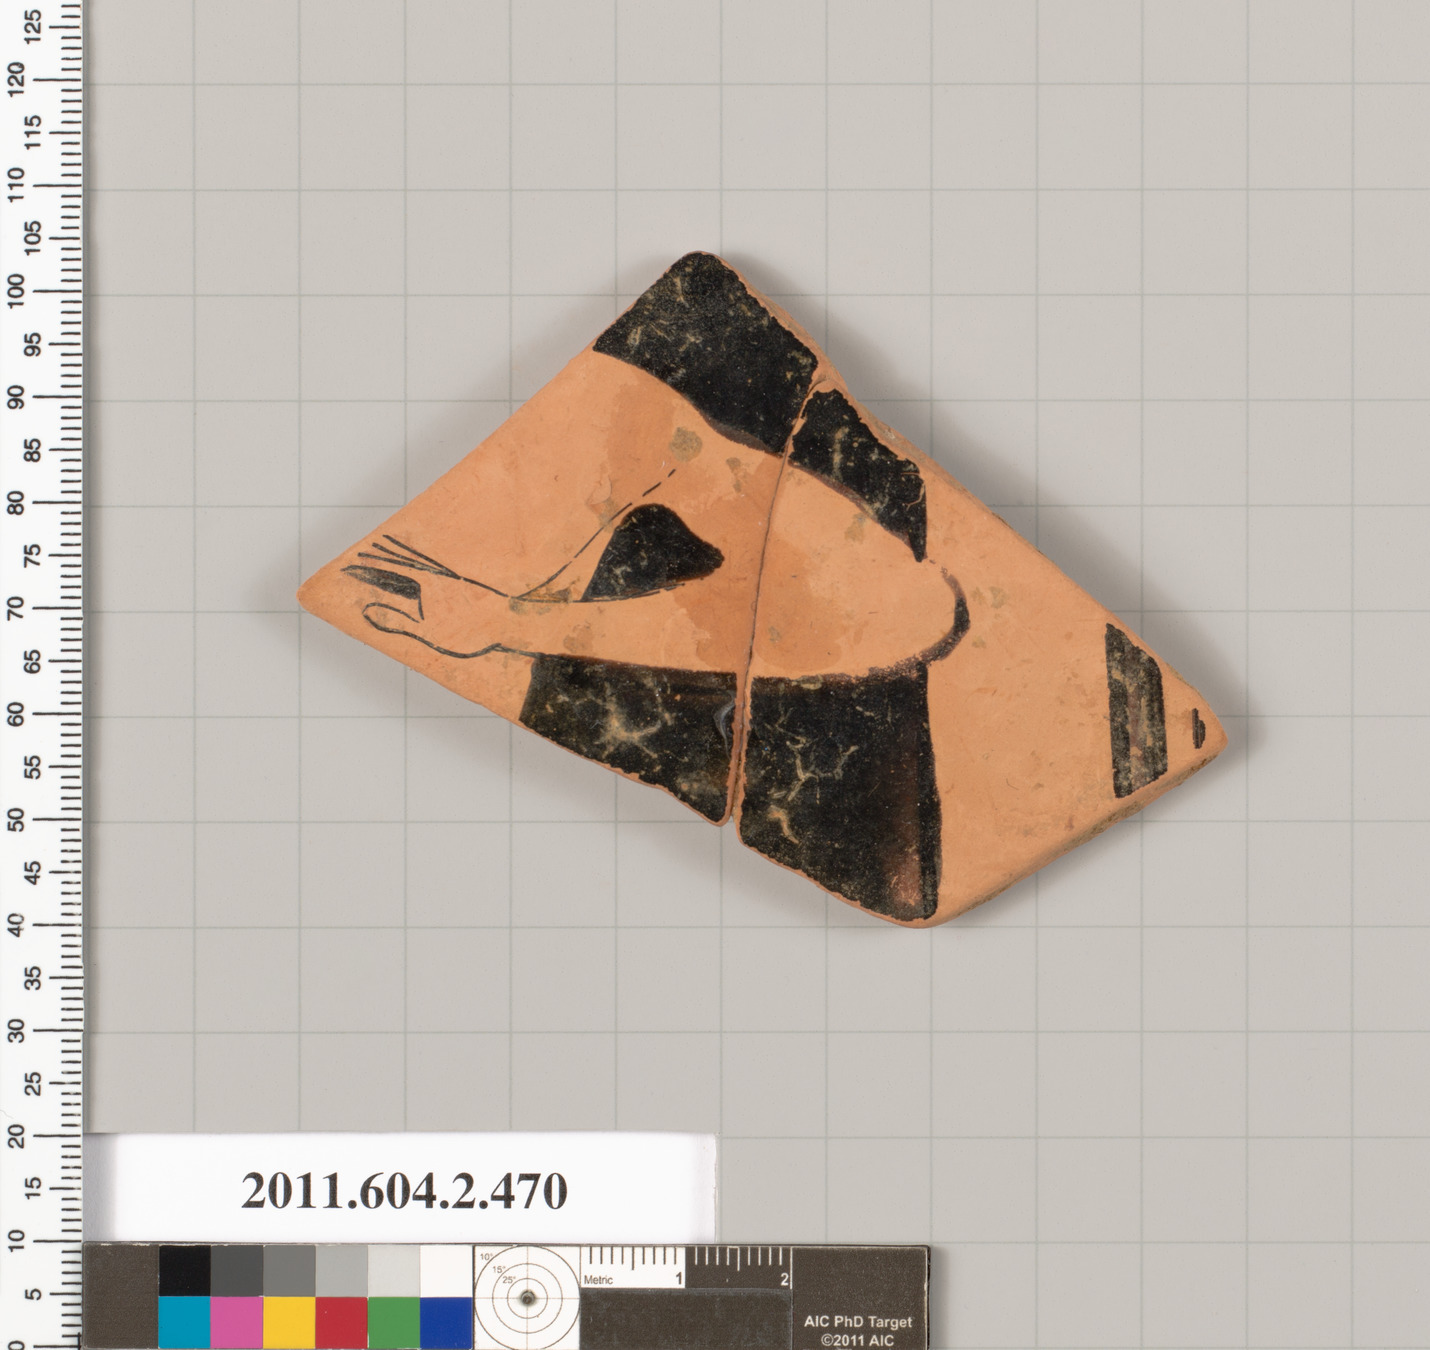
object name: column krater fragment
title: Terracotta fragment of a column-krater (bowl for mixing wine and water)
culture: greek, attic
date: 475-451 BCE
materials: terracotta